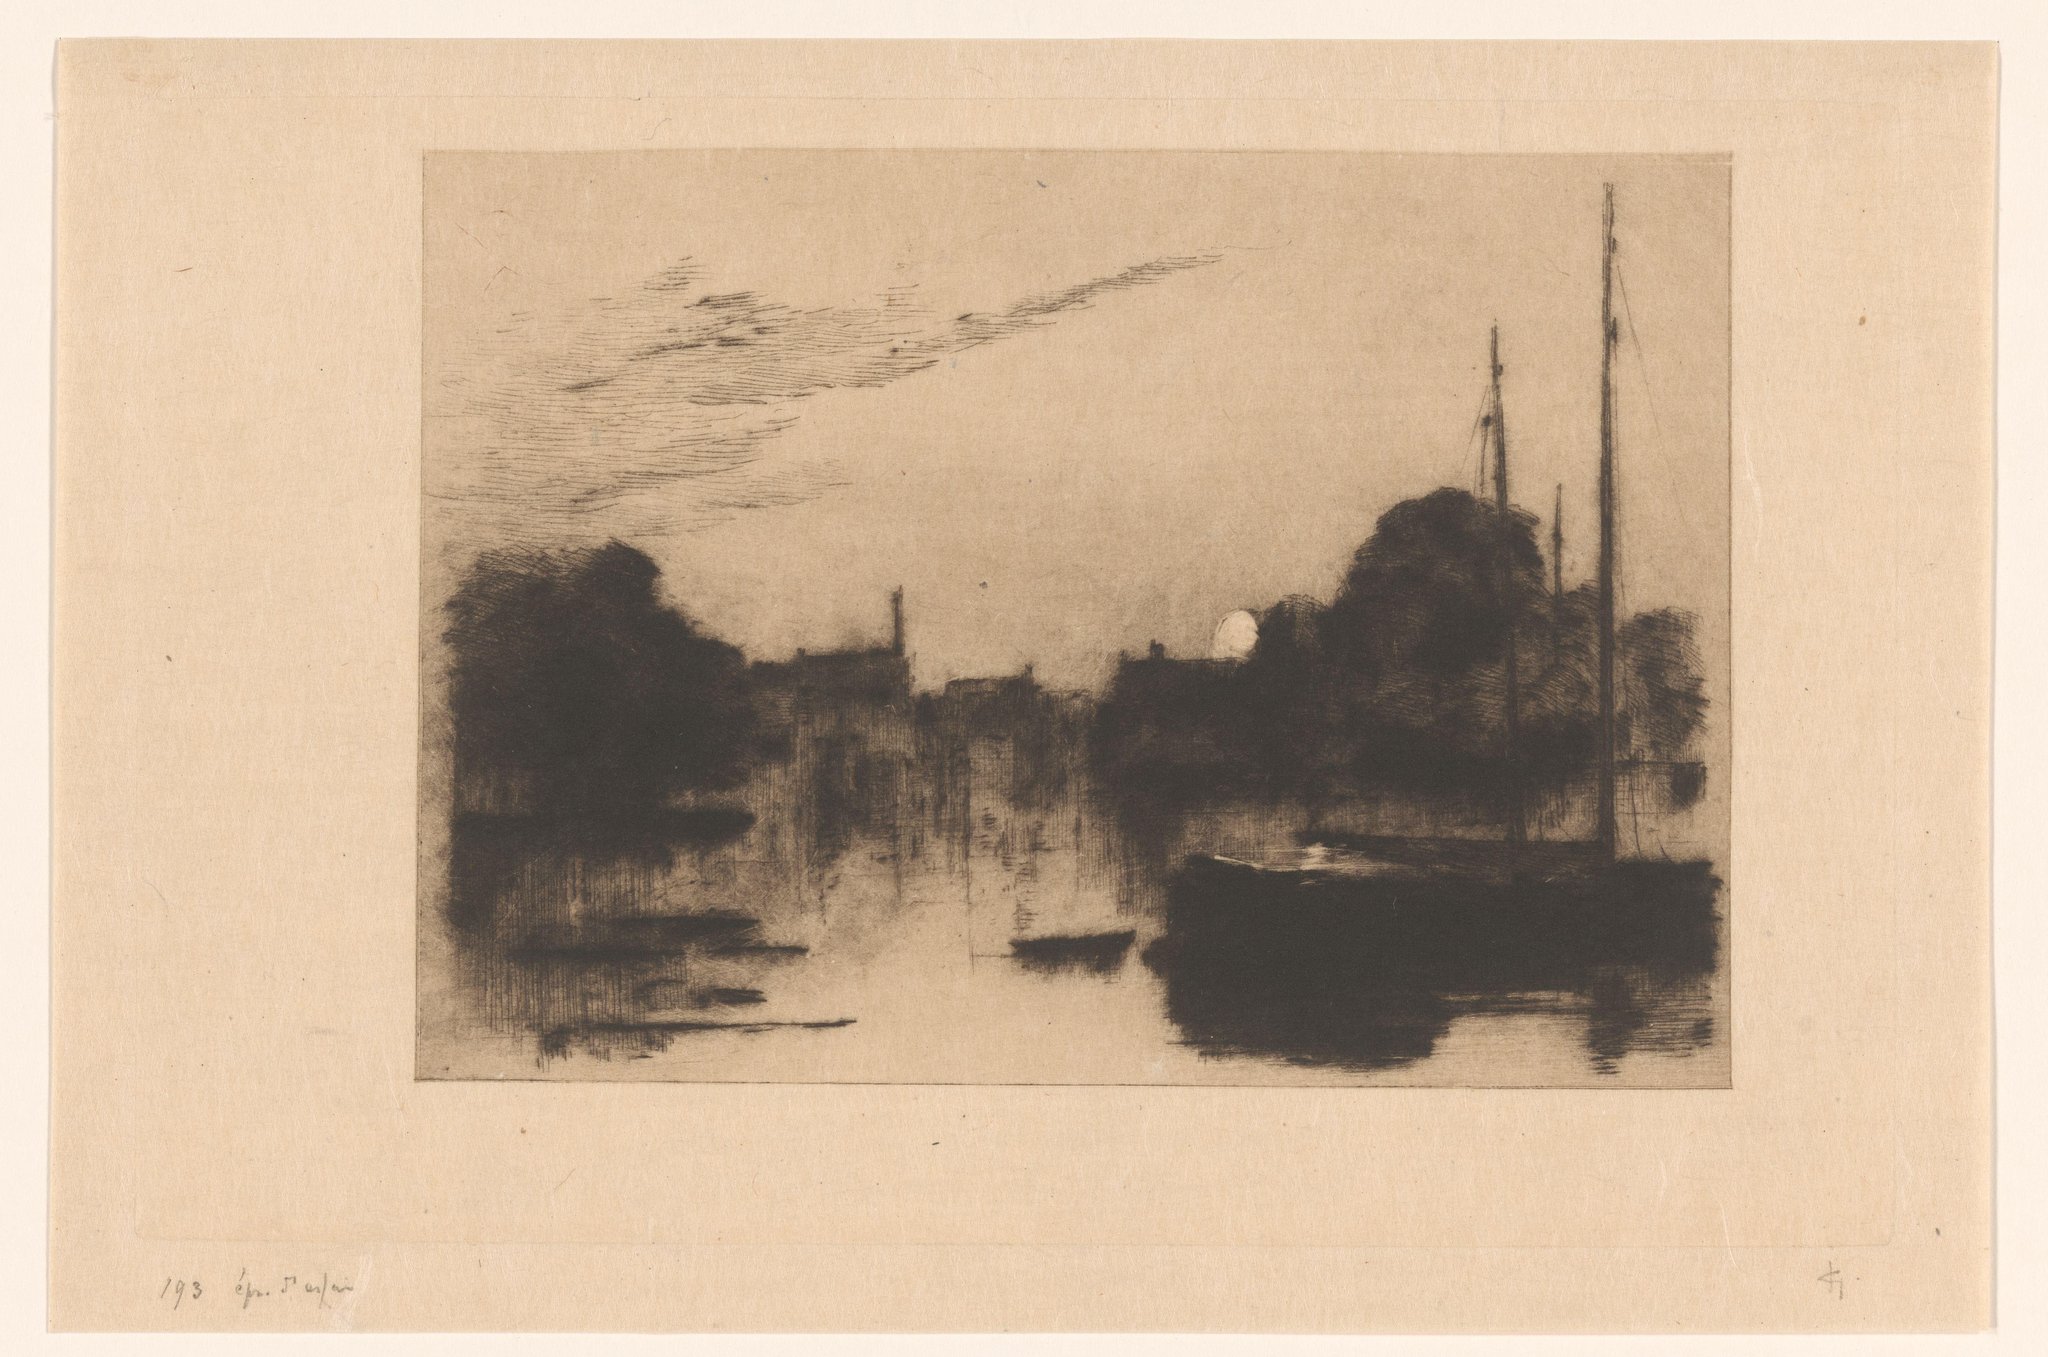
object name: print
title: Schetsen in Holland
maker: carel nicolaas storm van s-gravesande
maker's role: draughtsman, print maker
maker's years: 1841-1924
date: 1851-1887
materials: paper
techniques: drypoint, intaglio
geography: netherlands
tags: harbour, moonlight, dordrecht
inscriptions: collector's mark: Lugt 2228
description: Dit is de vijfde of twaalfde prent uit een serie van twaalf.